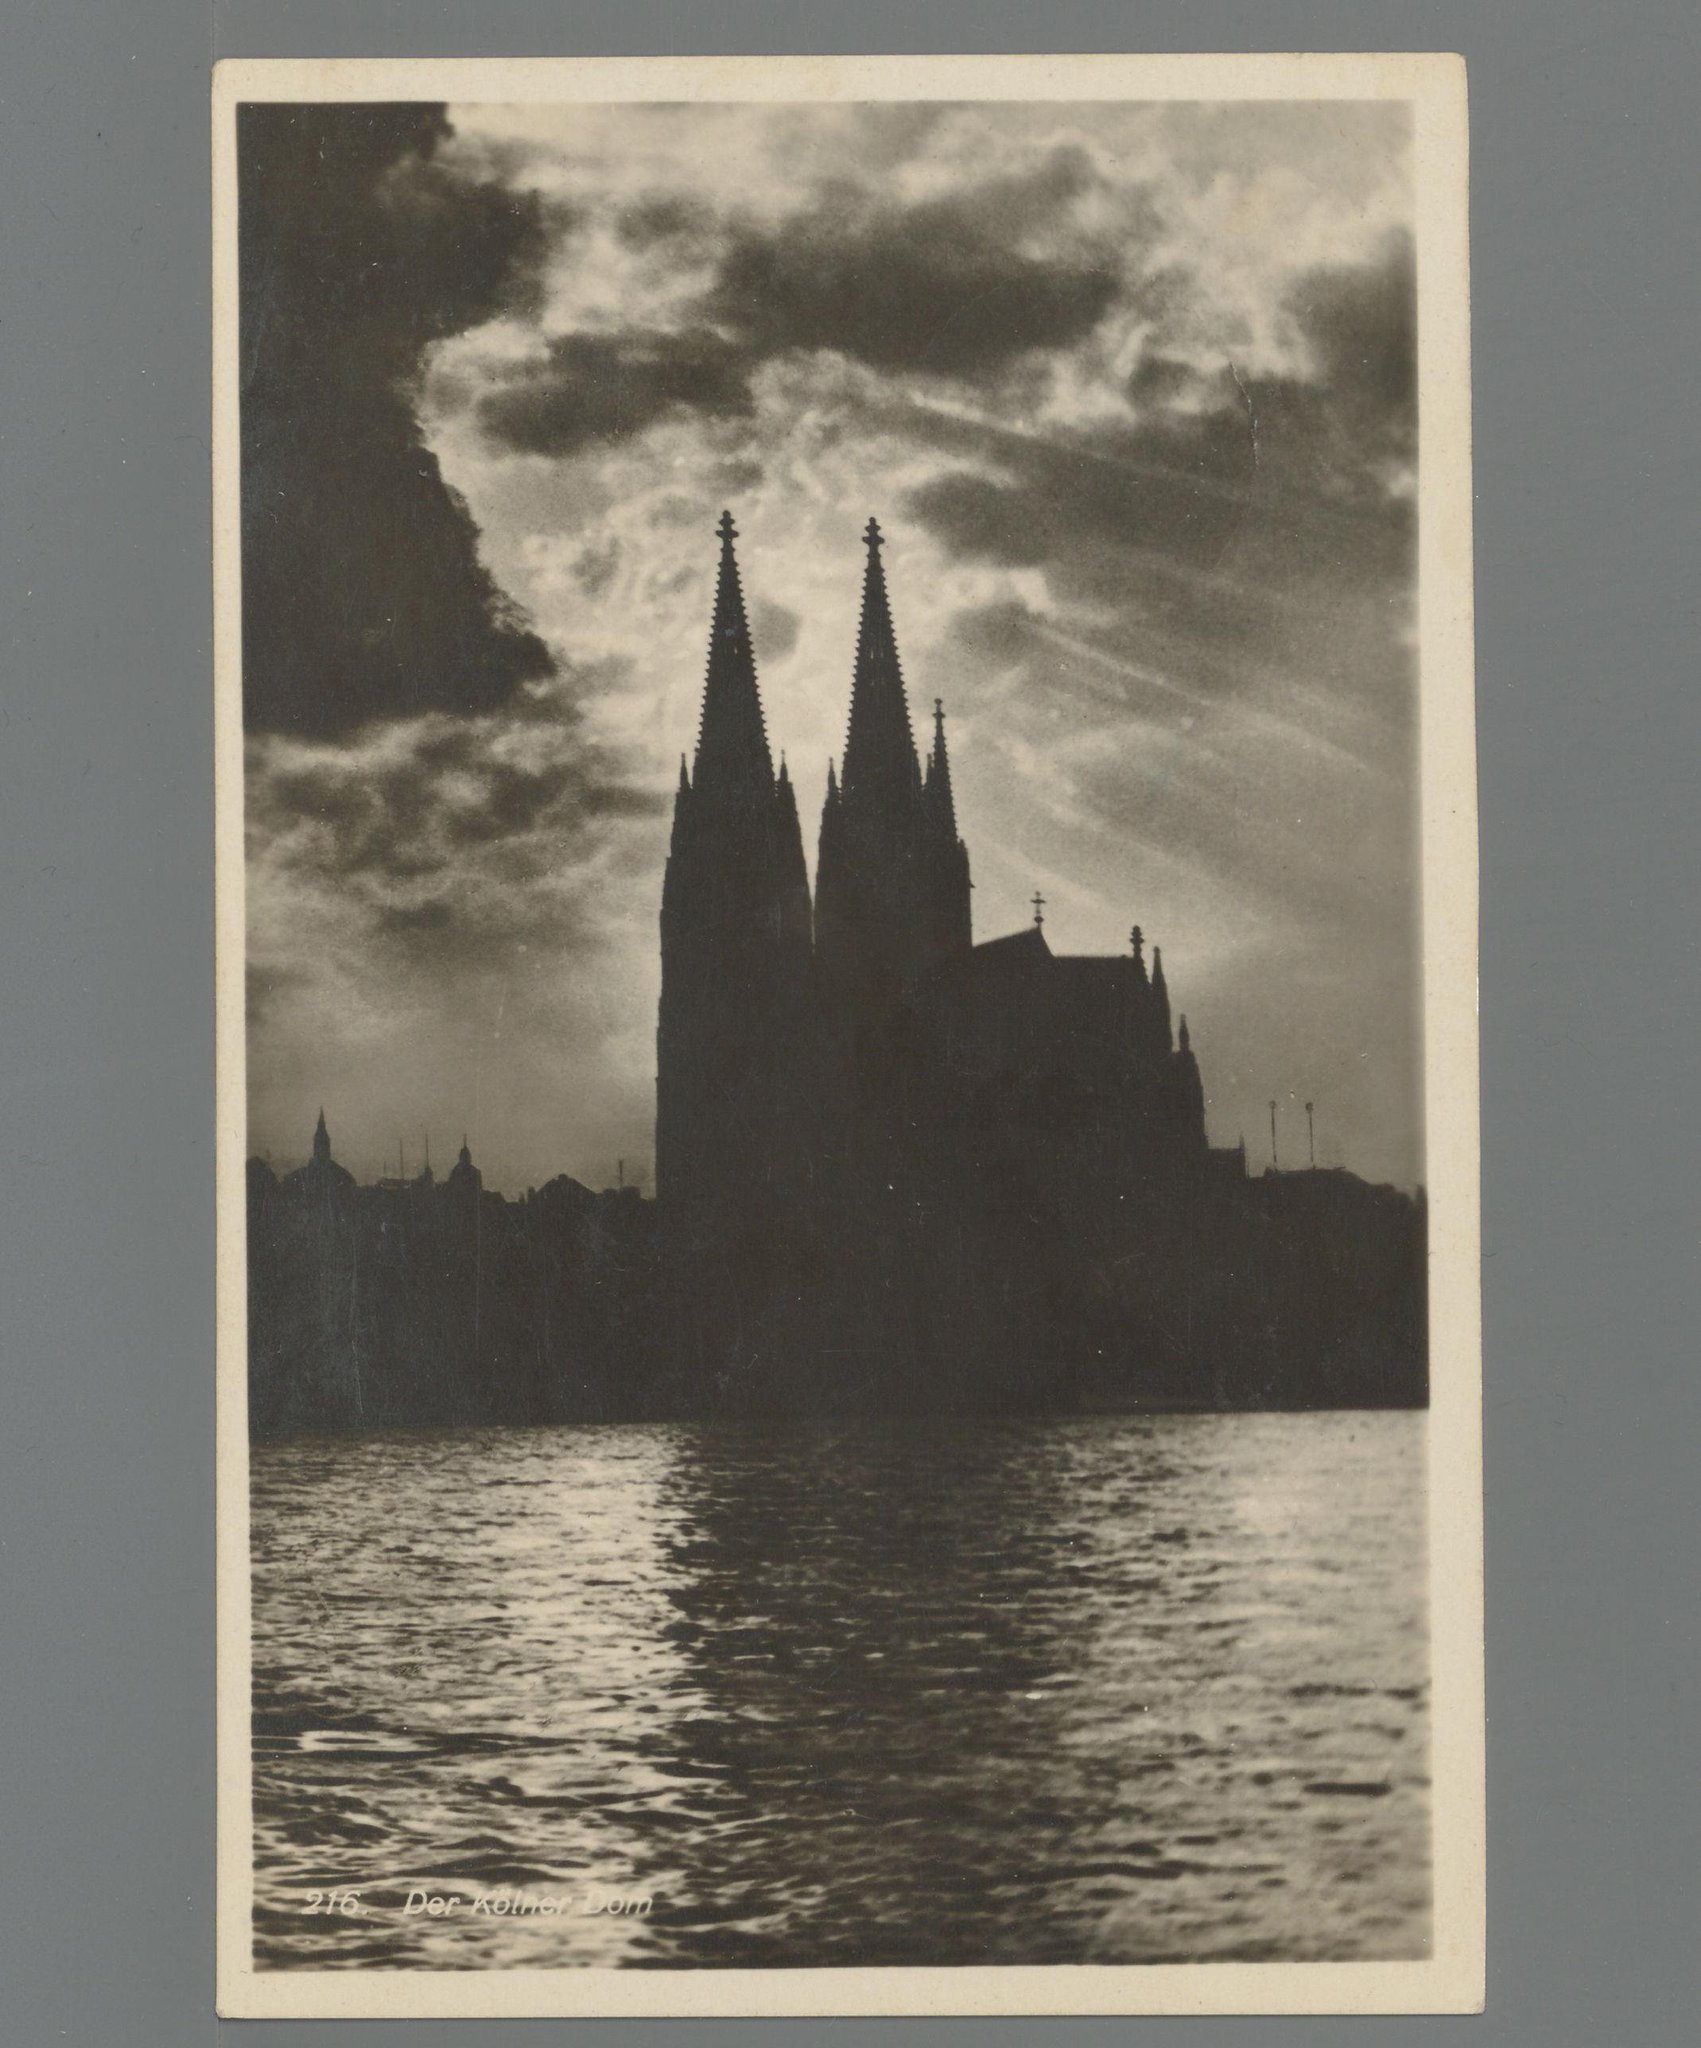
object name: photograph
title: Der Kölner Dom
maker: Anonymous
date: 1905-1930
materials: photographic support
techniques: gelatin silver print, writing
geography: cologne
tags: church (exterior), canals, waters (in city)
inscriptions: postage stamp